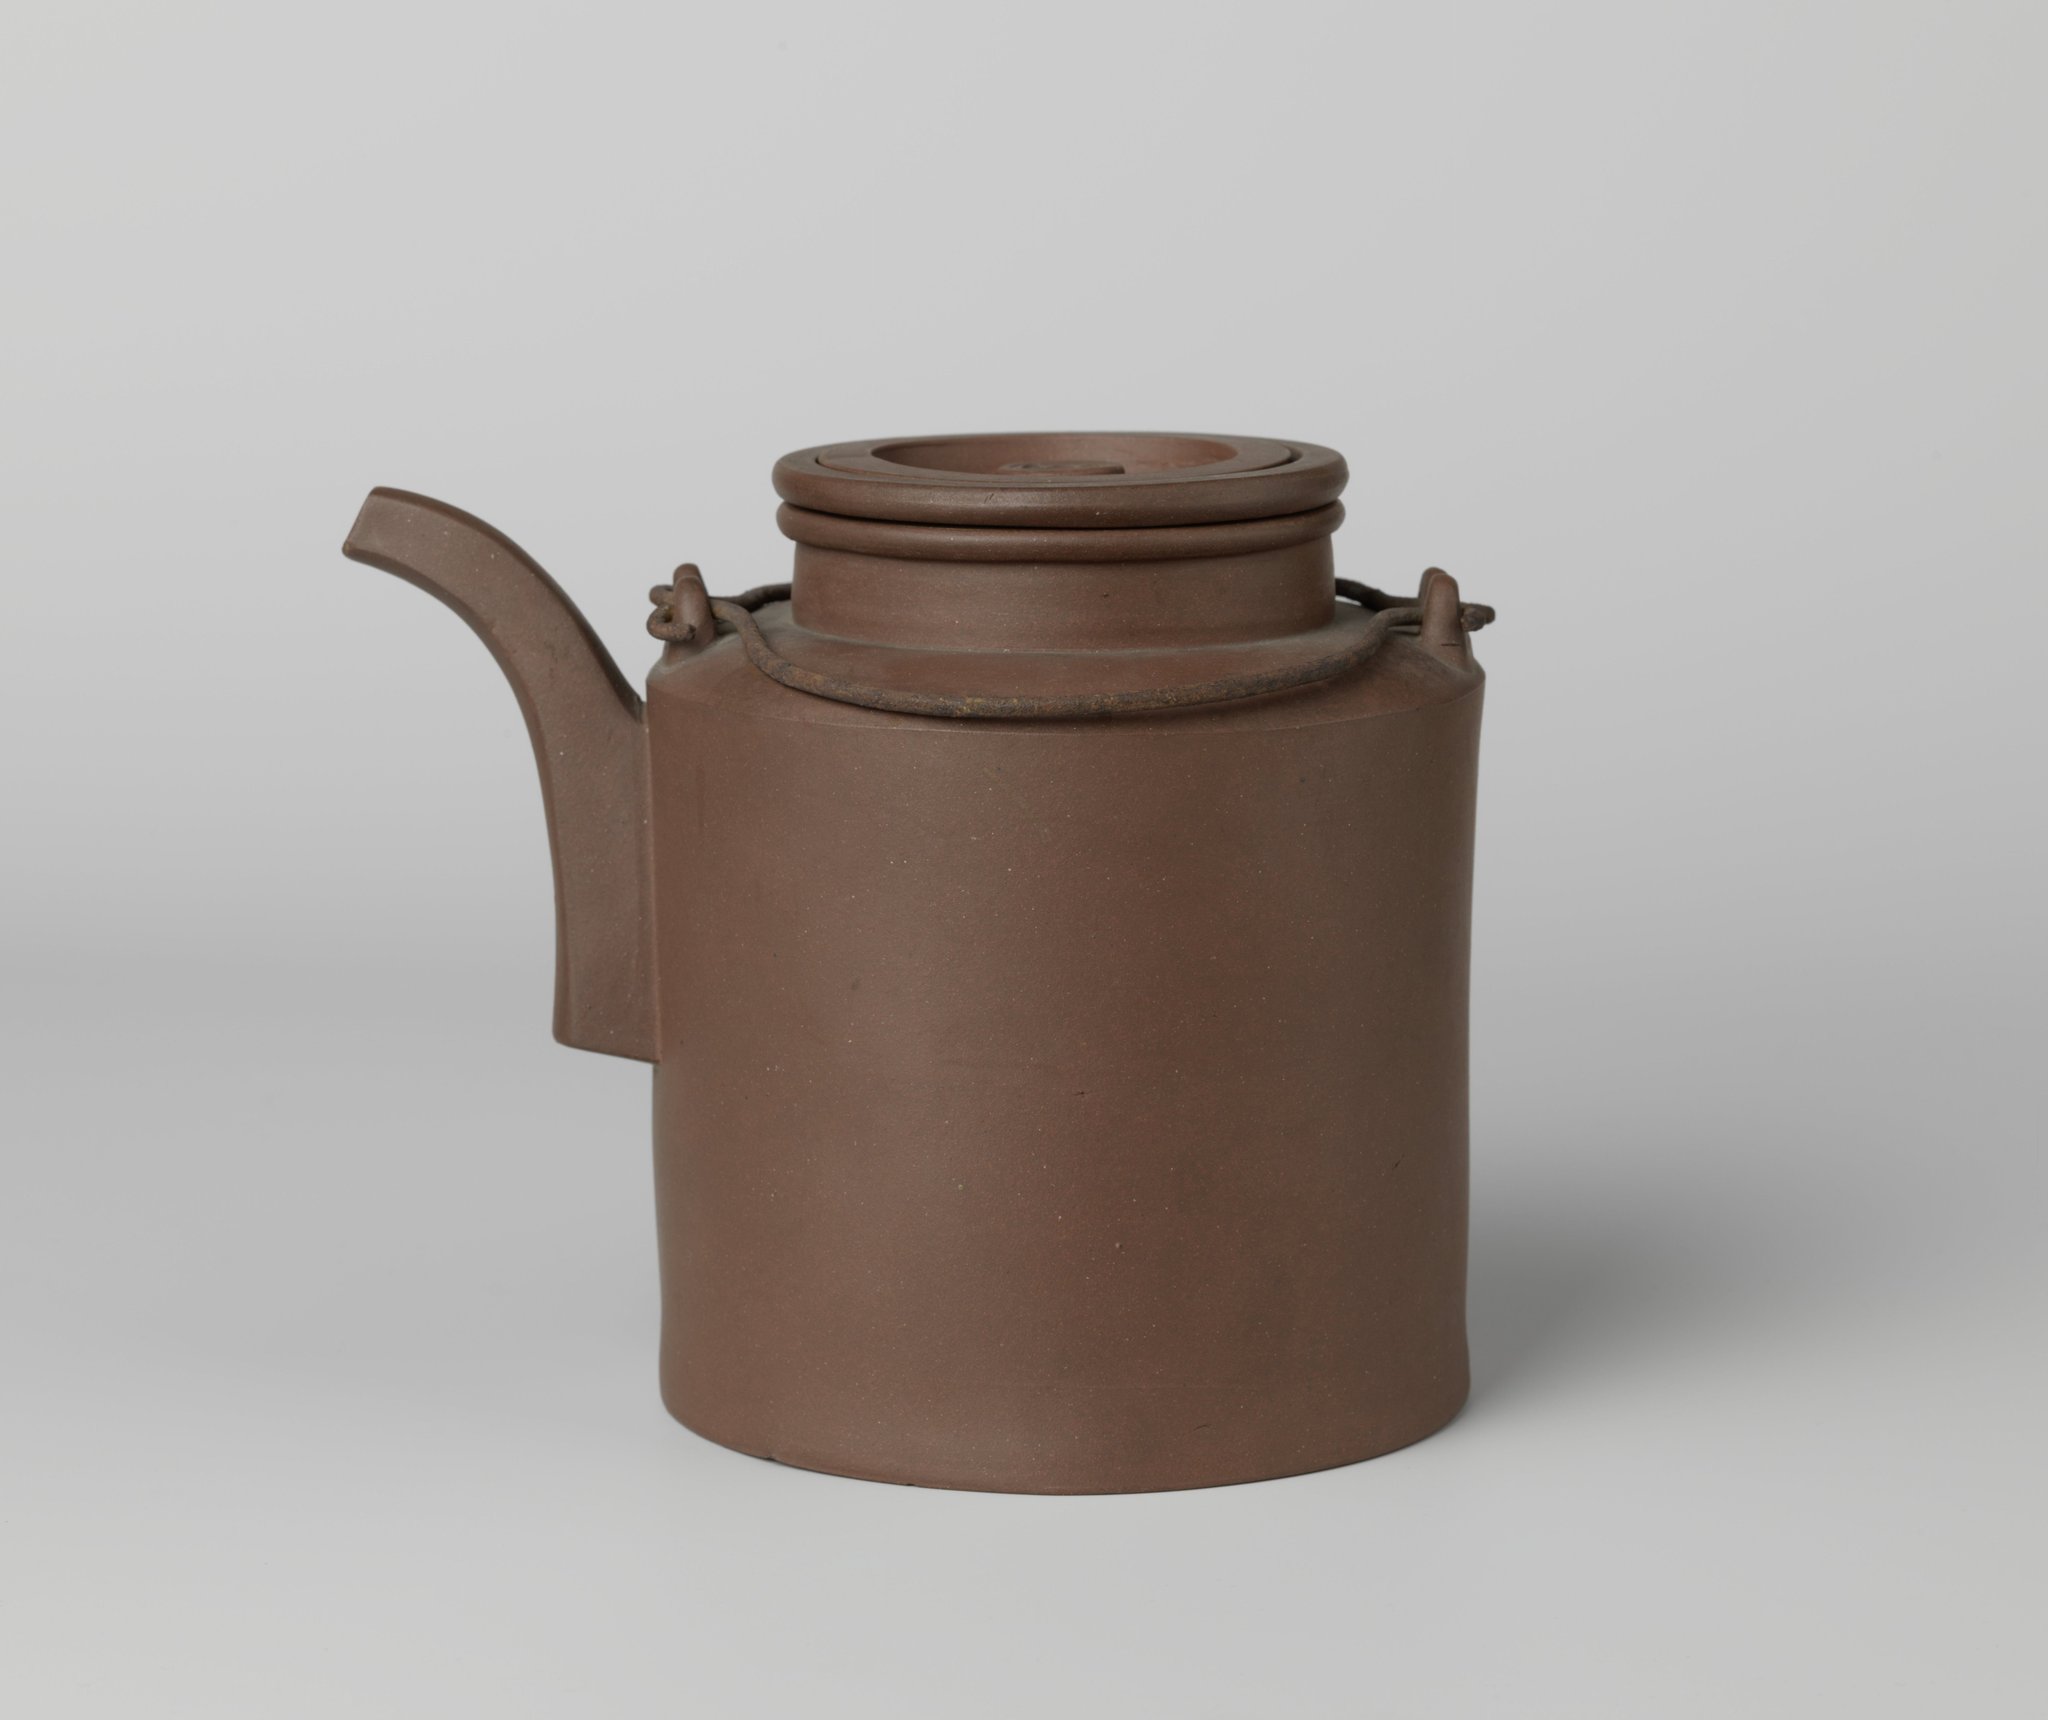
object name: teapot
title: Teapot with a Filter and Iron Handle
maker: Anonymous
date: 1800-1899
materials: iron, stoneware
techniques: forming, turning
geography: china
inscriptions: mark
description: This teapot has a round body and a square spout, and handles of iron. Inside the pot is a perforated stoneware infuser for the tea leaves. The pot’s shape deviates from traditional designs. For instance, the cover is hollow rather than convex, and the bottom is completely flat. It is possible that the teapot was inspired by objects made of metal.